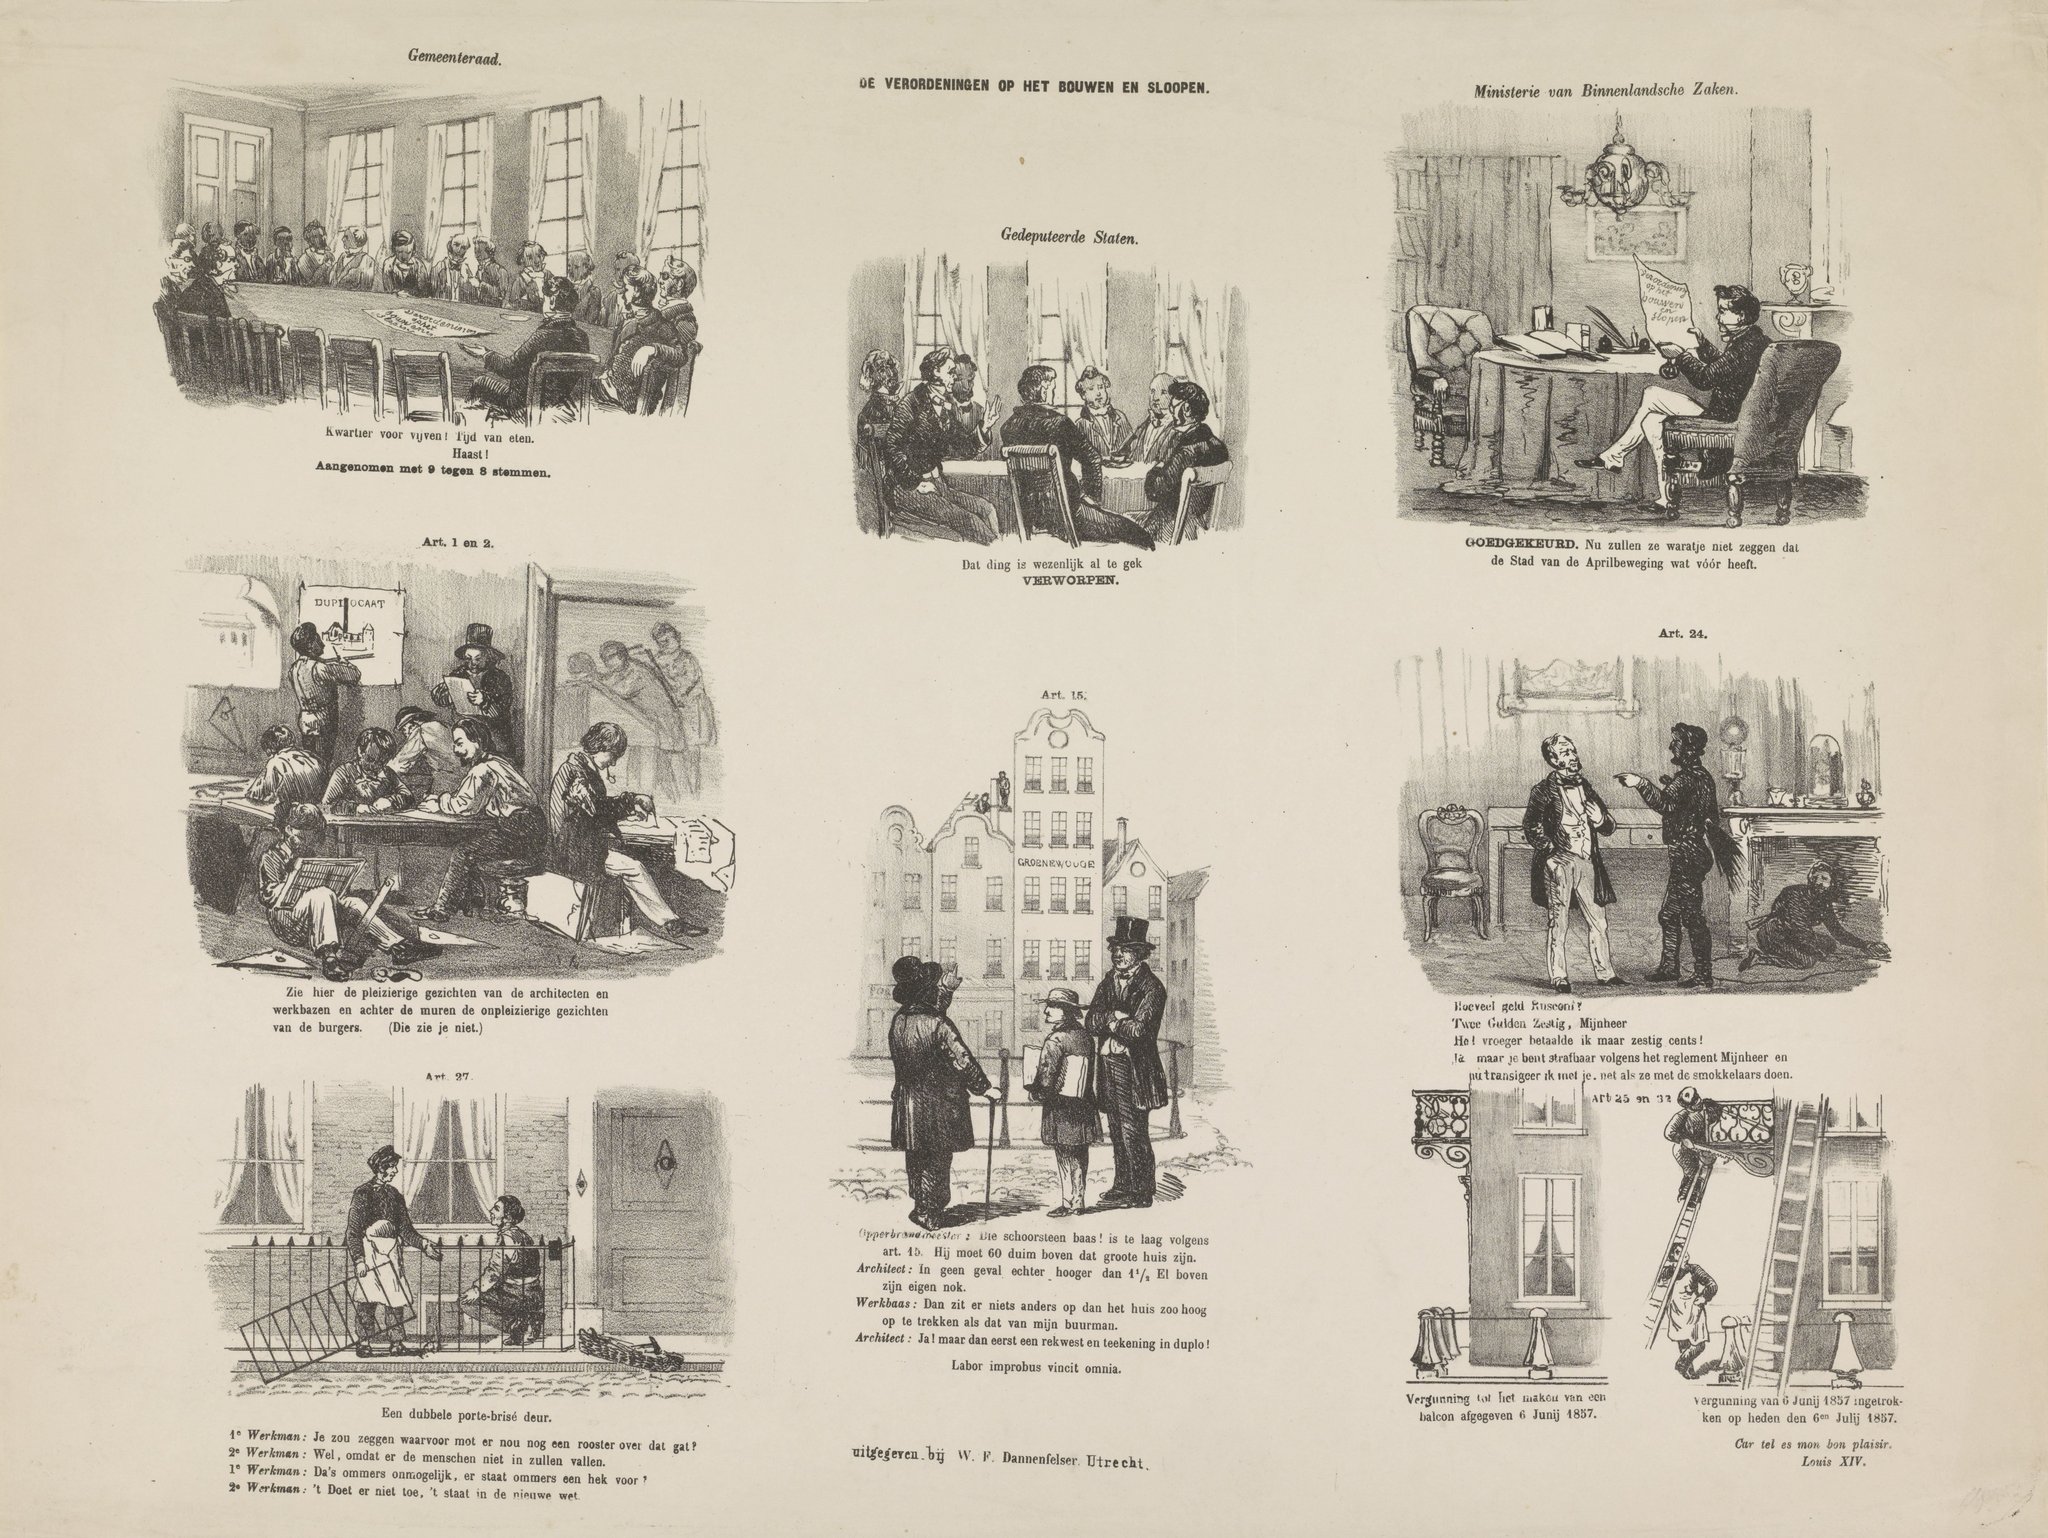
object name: cartoon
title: De verordeningen op het bouwen en sloopen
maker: Anonymous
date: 1857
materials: paper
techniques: lithograph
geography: netherlands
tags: building activities, civil law, municipal government, utrecht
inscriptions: collector's mark: Lugt 2228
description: Spotprent op de zonderlinge gevolgen en tegenstrijdigheden waartoe een - niet aangenomen - verordening op het bouwen en slopen zou hebben geleid, Utrecht, juni-juli 1857. Acht aparte scènes, elk met een onderschrift en een verwijzing naar het relevante artikel.